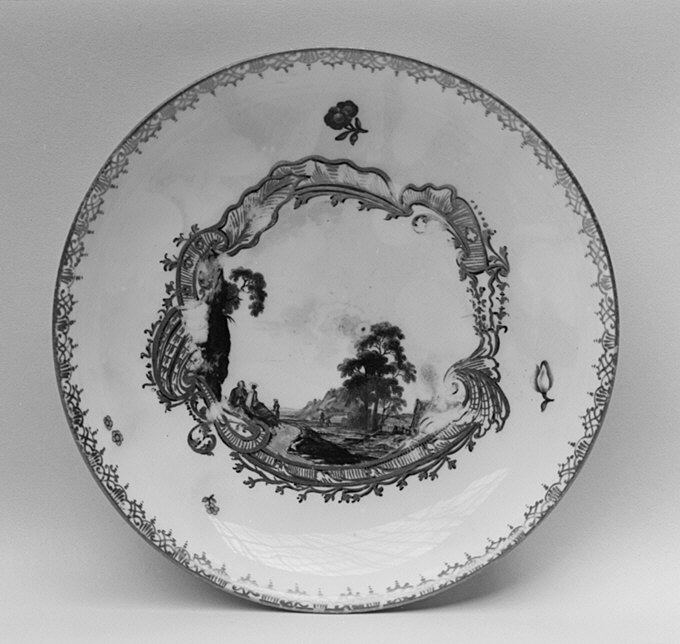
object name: saucer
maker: meissen manufactory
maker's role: manufactory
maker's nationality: german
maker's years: 1710-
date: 1745-1750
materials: hard paste porcelain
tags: human figures,flowers,landscapes,trees